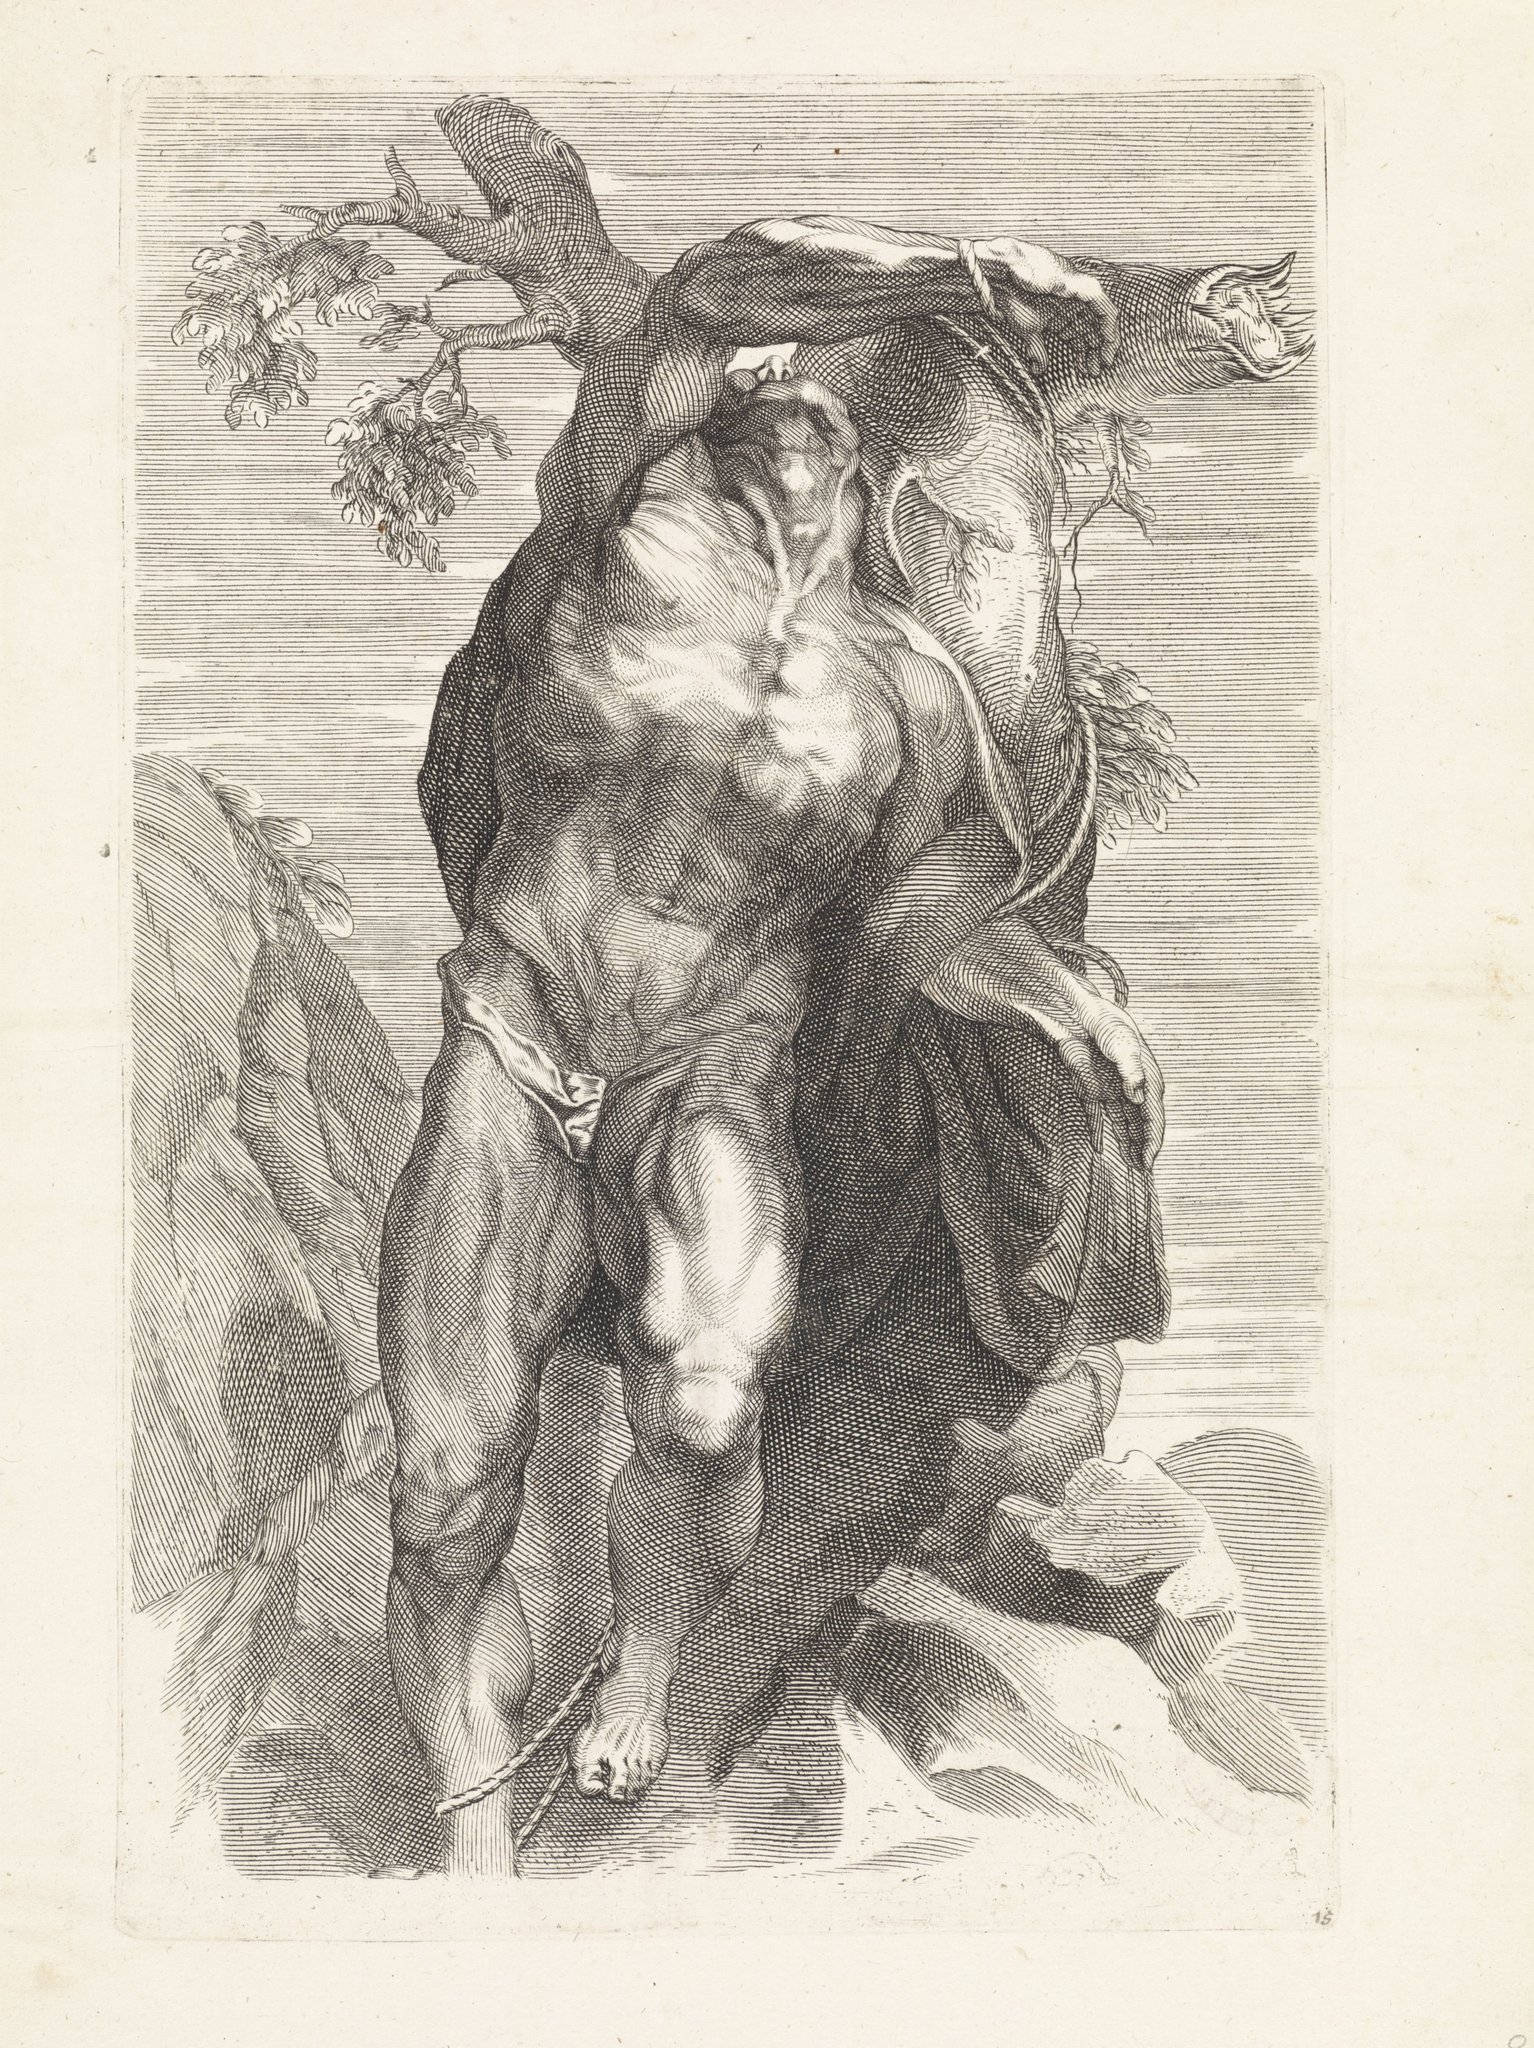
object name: print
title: Anatomische studie van een man die aan een boom is gebonden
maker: paulus pontius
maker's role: draughtsman, print maker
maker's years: 1603-1658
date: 1616-1657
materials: paper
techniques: engraving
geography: antwerp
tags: parts of the human body (skeleton excepted), trees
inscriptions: collector's mark: Lugt 240, number: ‘15’